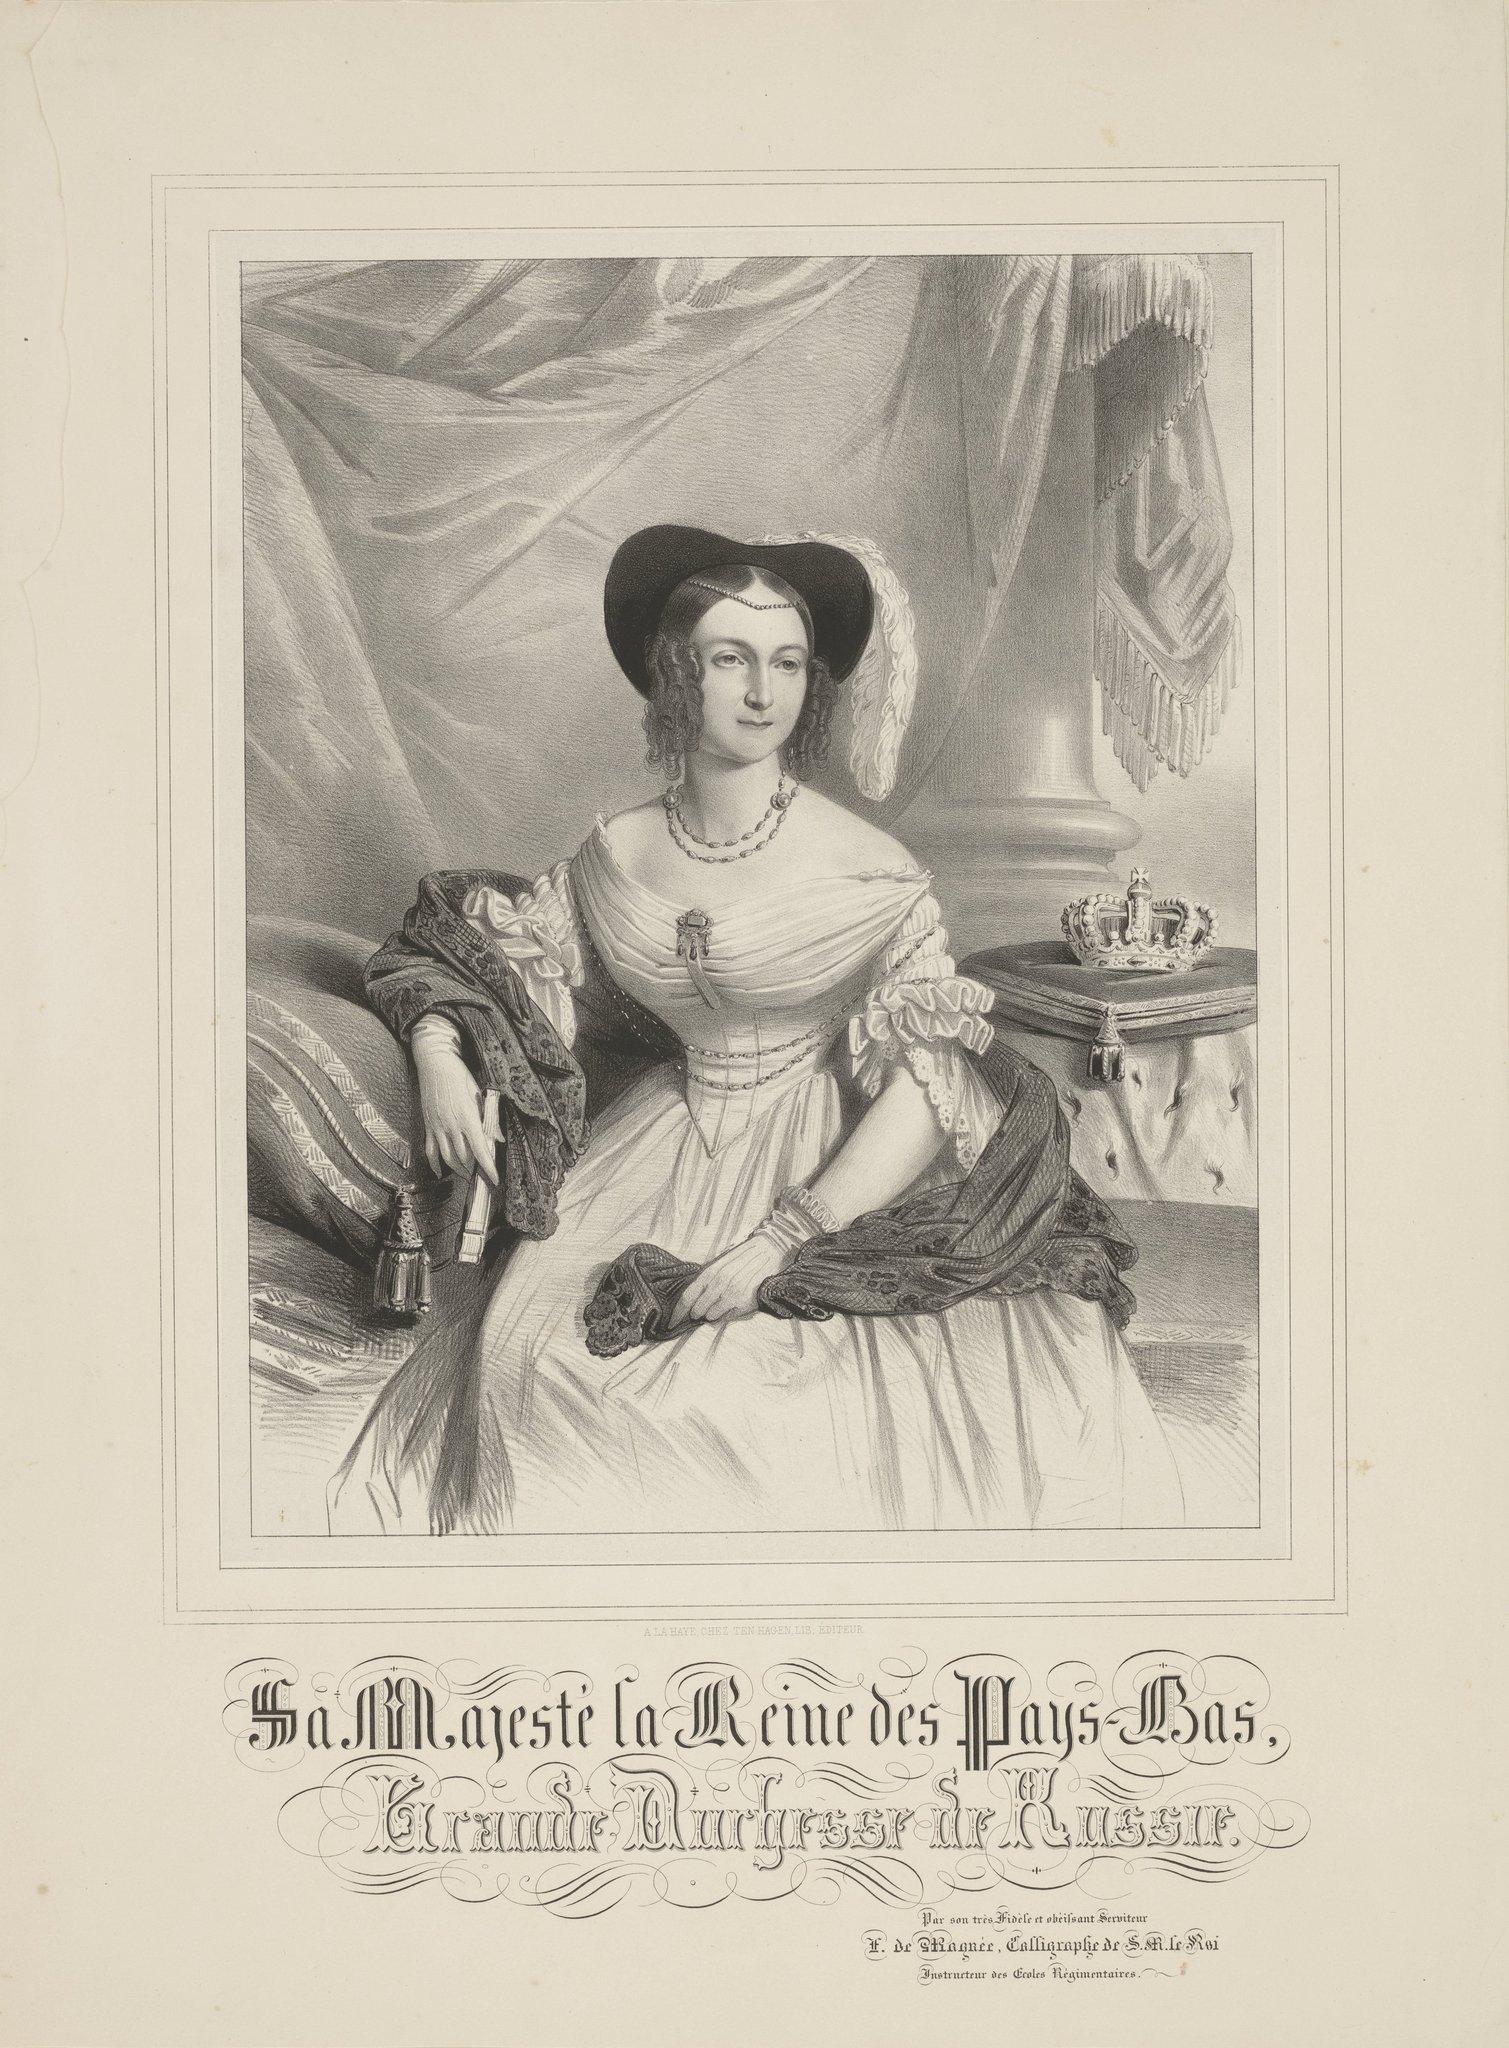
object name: print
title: Portret van Anna Paulowna Romanowa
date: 1840-1865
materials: paper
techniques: lithograph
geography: brussels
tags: anna paulowna romanowa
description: Portret van Anna Paulowna. Ze zit naast een tafel met daarop een kroon. In haar rechterhand een waaier. In de ondermarge haar titels.